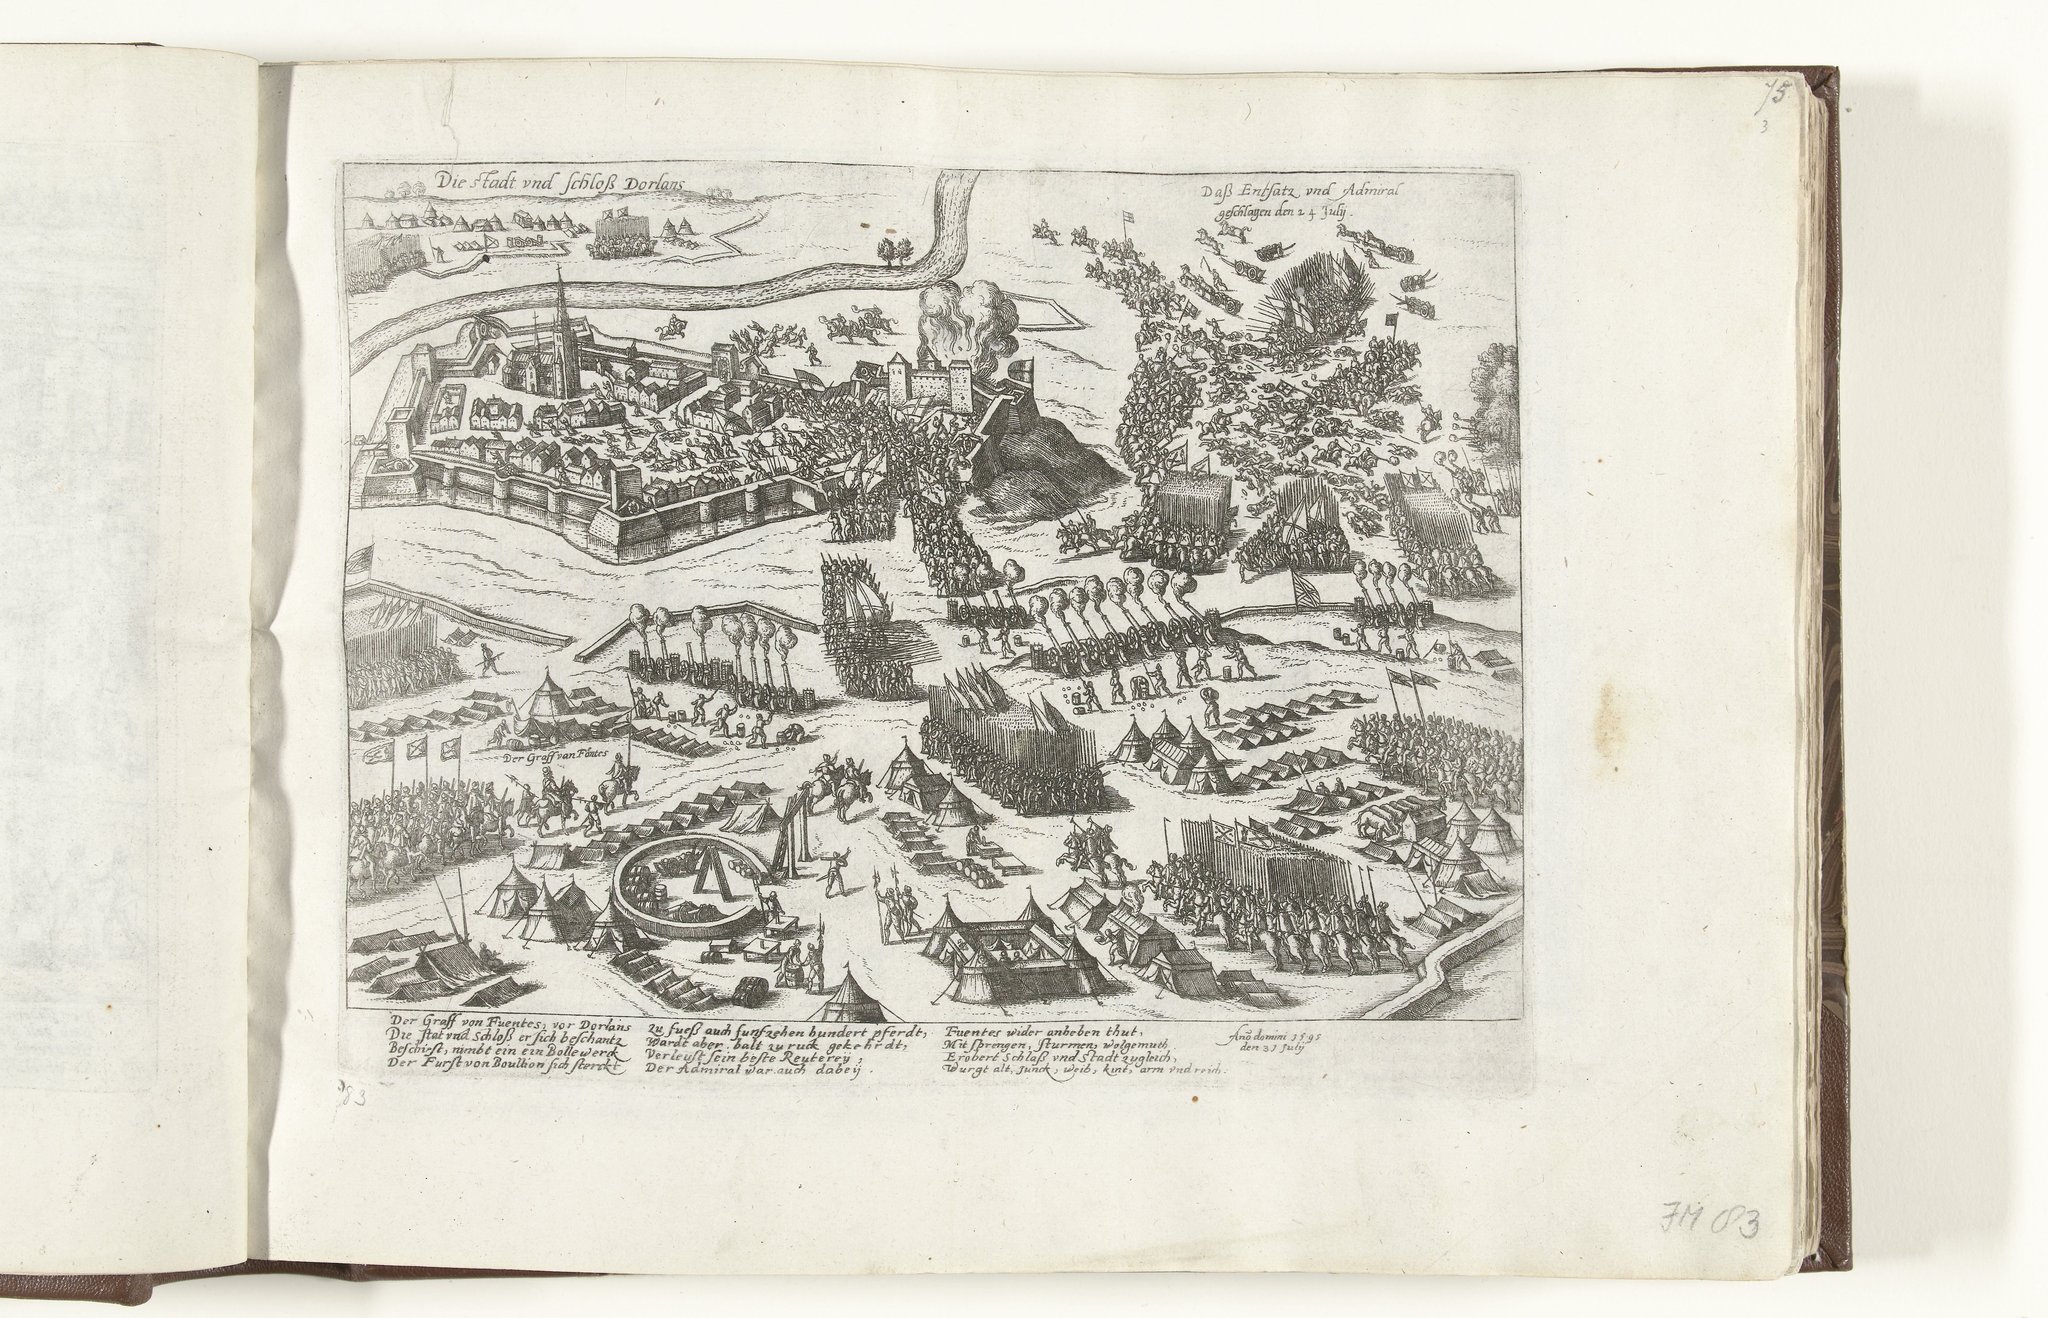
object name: print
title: Serie 4: Franse, Duitse en Engelse Gebeurtenissen, 1576-1610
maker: frans hogenberg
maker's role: print maker, publisher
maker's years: 1538-1590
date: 1595-1612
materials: paper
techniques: etching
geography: cologne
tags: politician, pedro enríquez de acevedo (count of fuentes), battle, fighting in general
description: De Spaanse graaf van Fuentes verovert Doullens aan de Somme, 31 juli 1595. Gezicht op het legerkamp van de Spaanse troepen. Met onderschrift van 12 regels in het Duits. Ongenummerd.